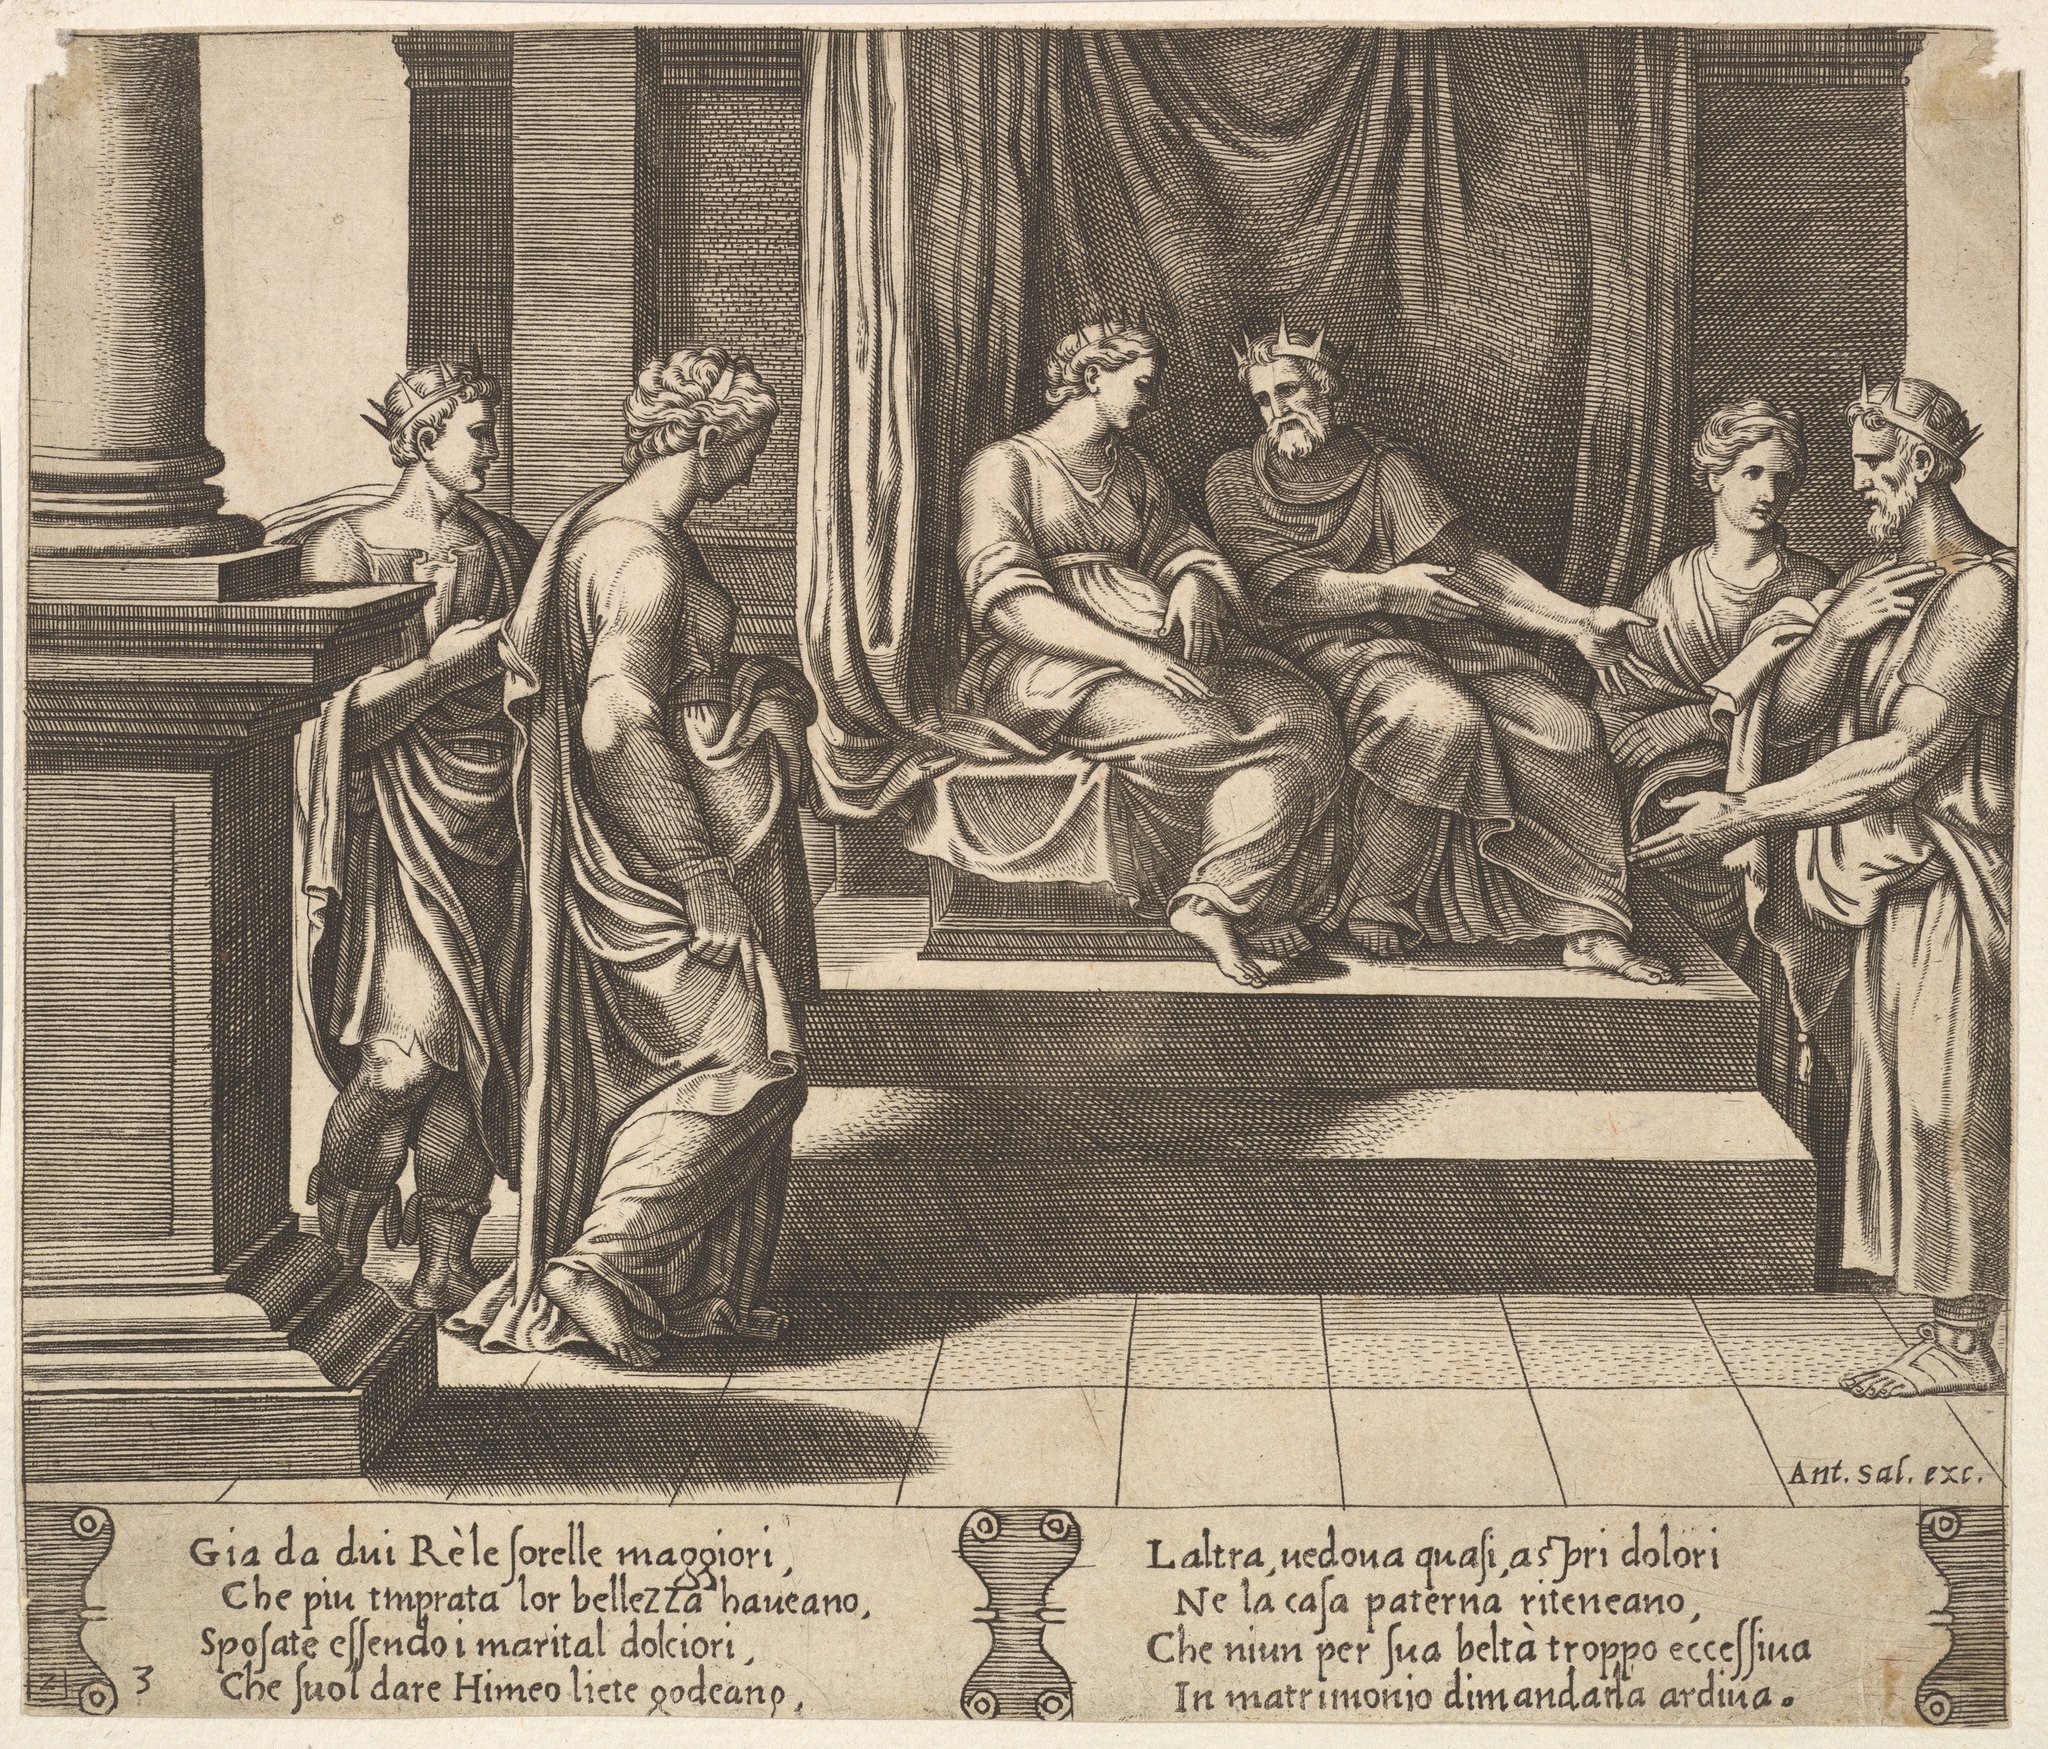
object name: print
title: Plate 3: Psyche's two sisters are married to kings, from "The Fable of Psyche"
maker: master of the die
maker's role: artist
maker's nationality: italian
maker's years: 1525-1560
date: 1530-1560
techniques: engraving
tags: kings,men,women